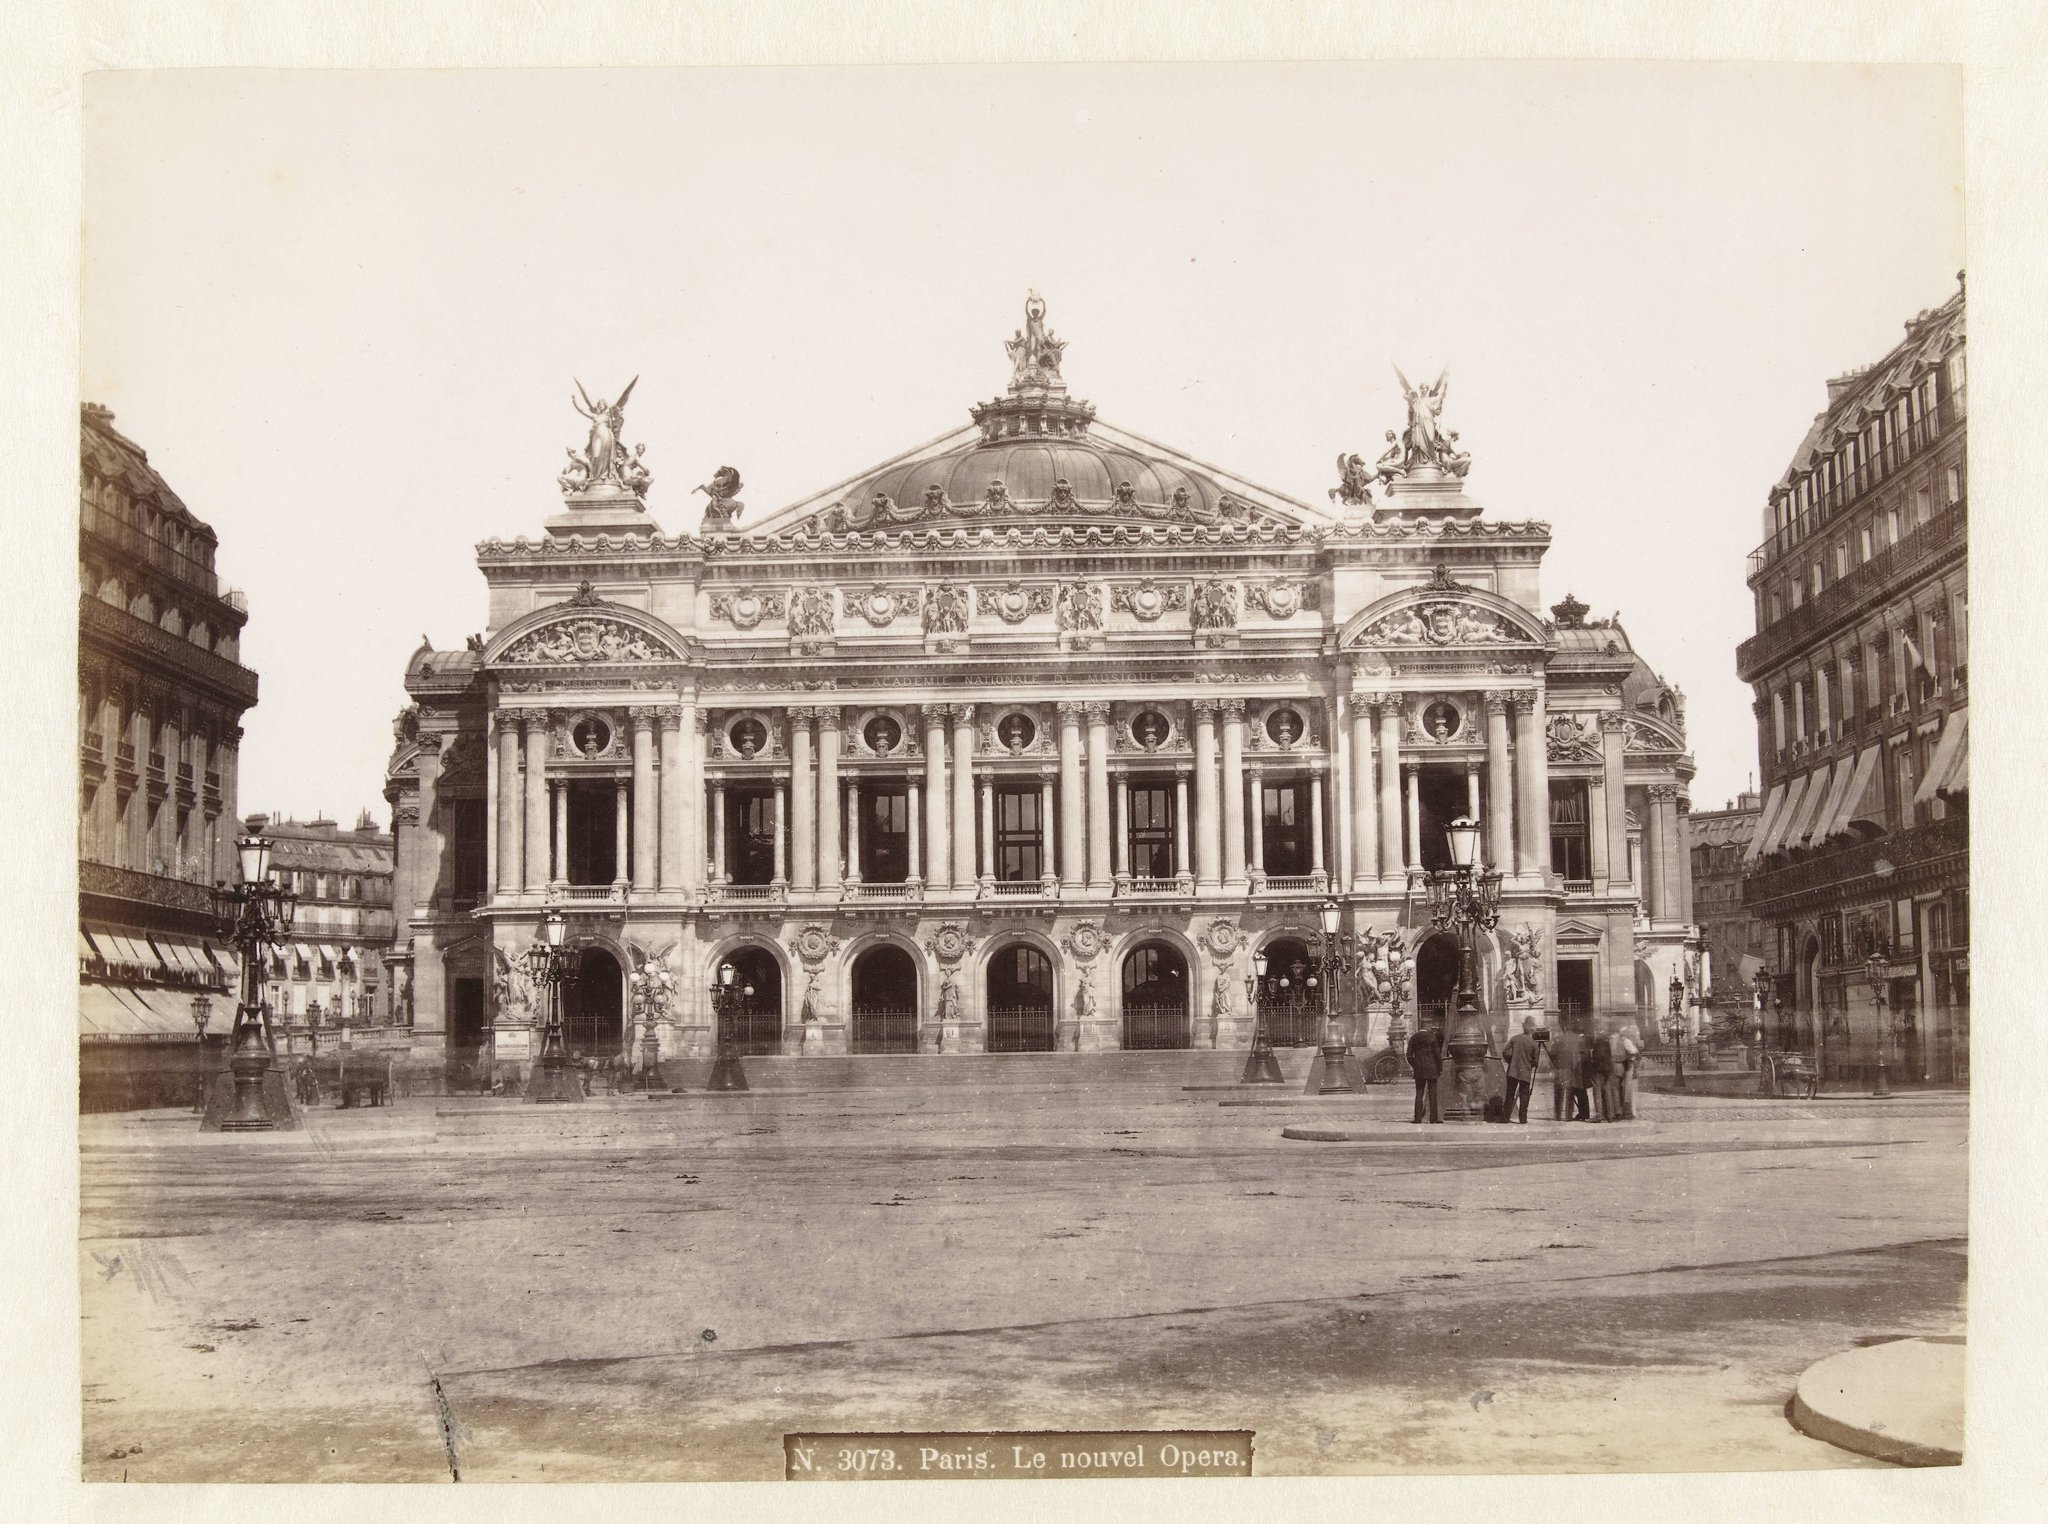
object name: photograph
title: Exterieur van de Opéra Garnier te Parijs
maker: Anonymous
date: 1875-1900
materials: paper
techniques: albumen print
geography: paris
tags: square, place, circus, etc., taking photographs - cc - out of doors, opera house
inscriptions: title: ‘N. 3073. Paris. Le nouvel Opera’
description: Rechts bij de lantaarnpaal staat een fotograaf.